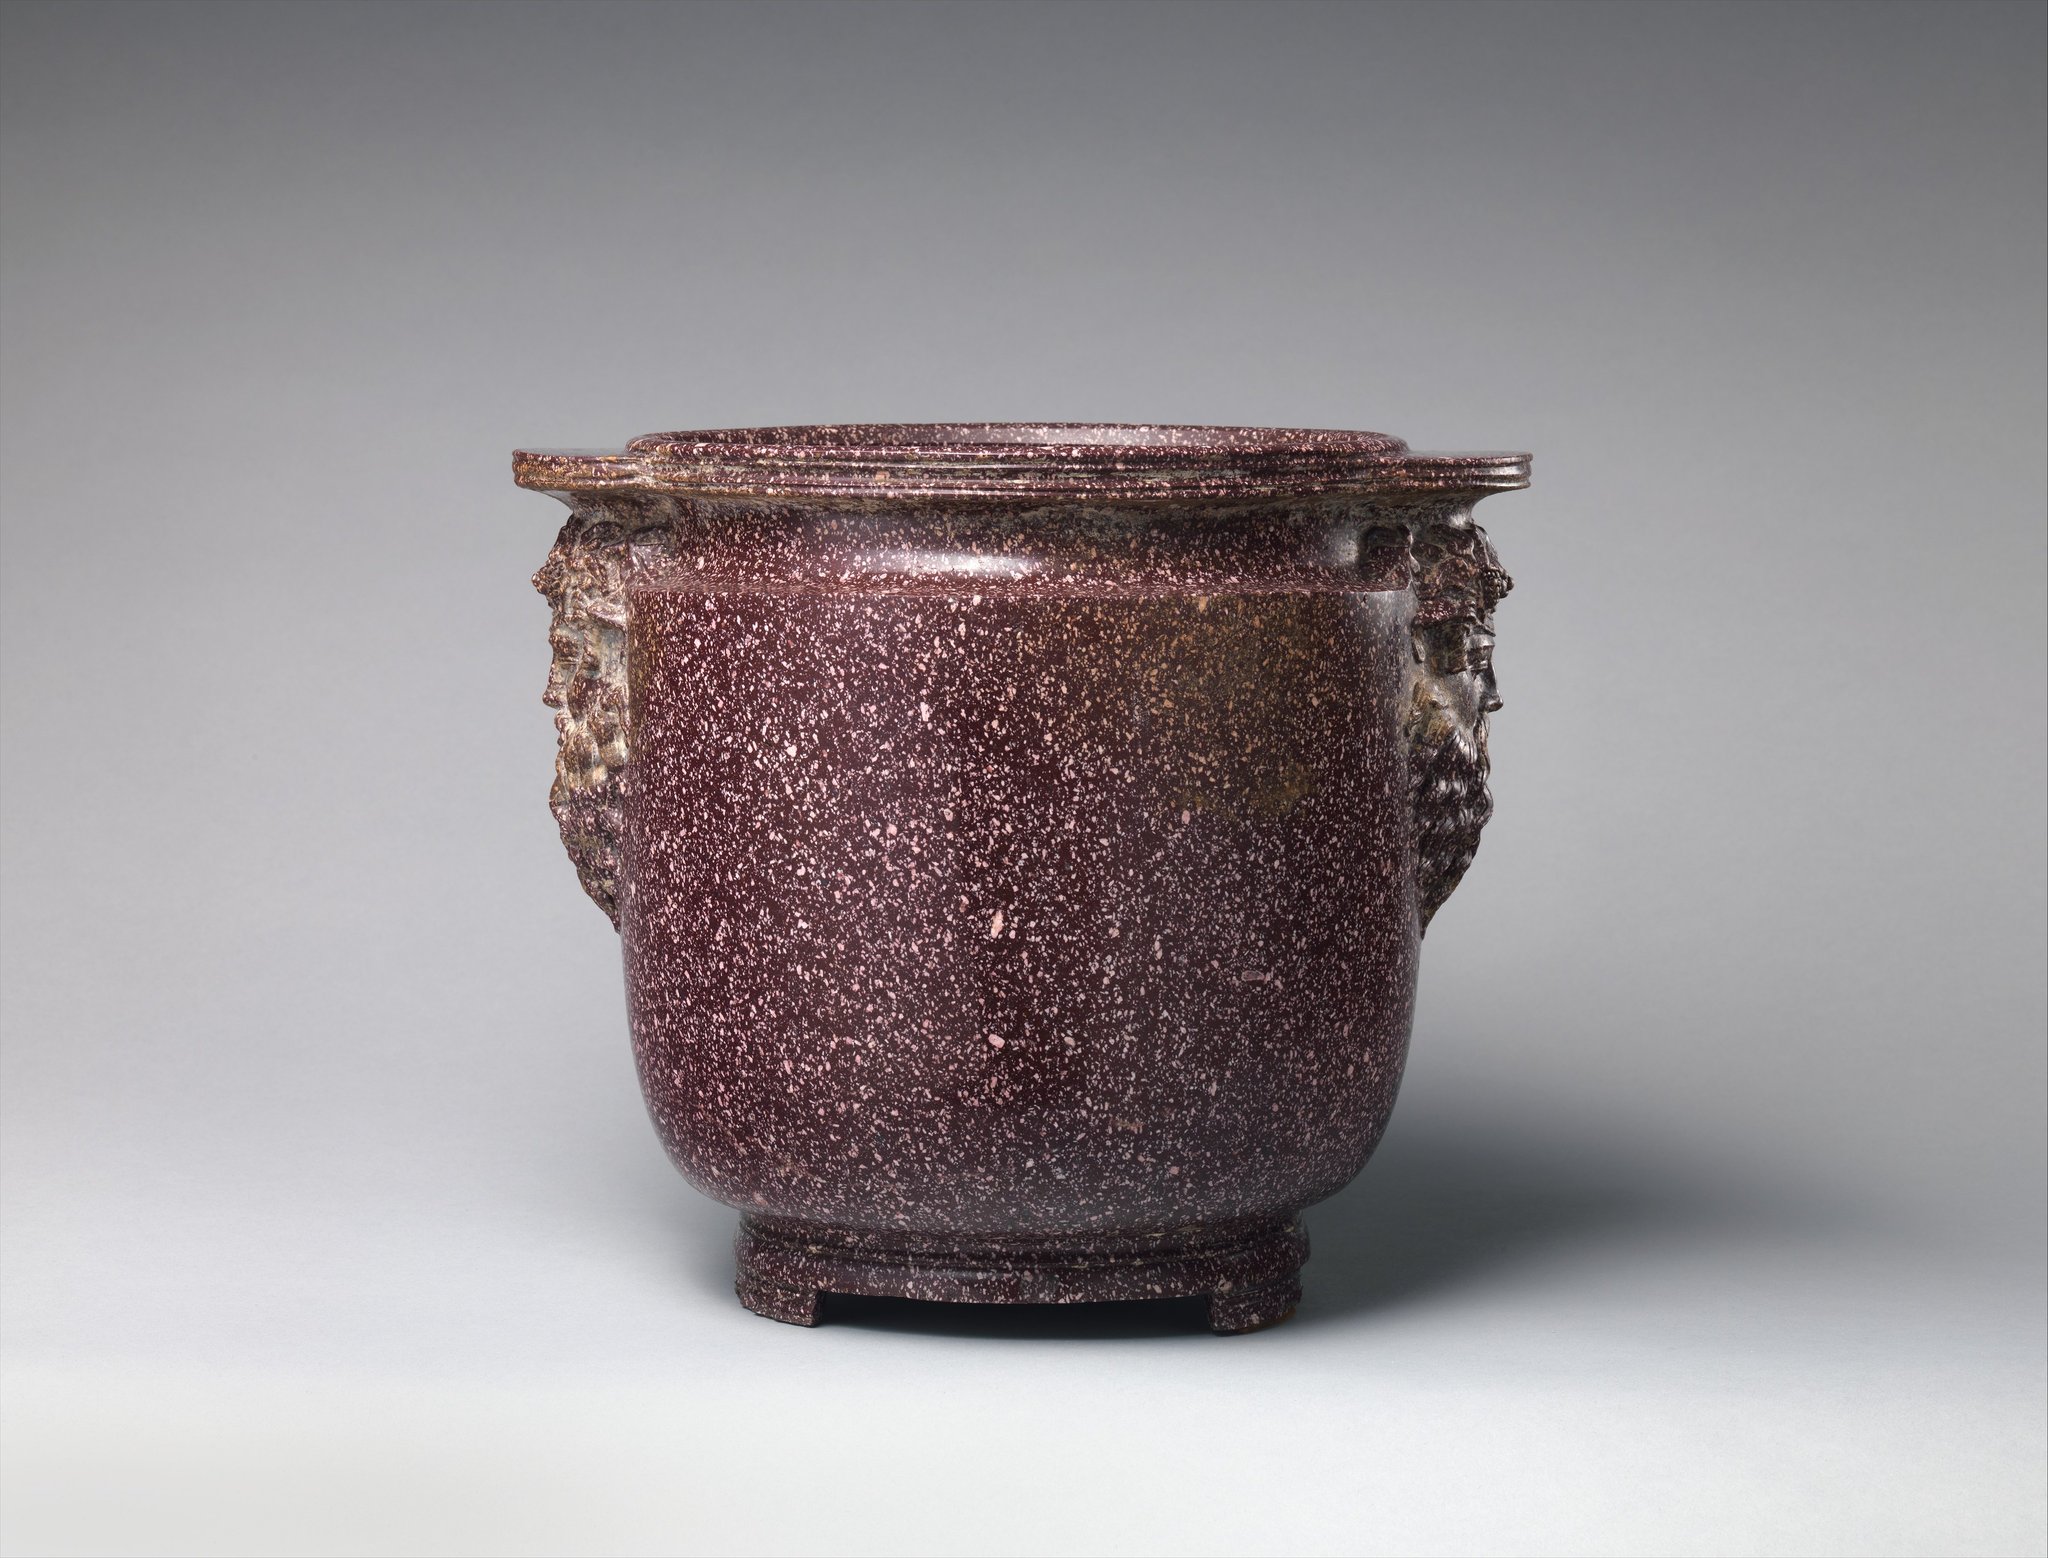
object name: cinerary urn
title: Porphyry vessel with bearded masks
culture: roman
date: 67-100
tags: masks,men